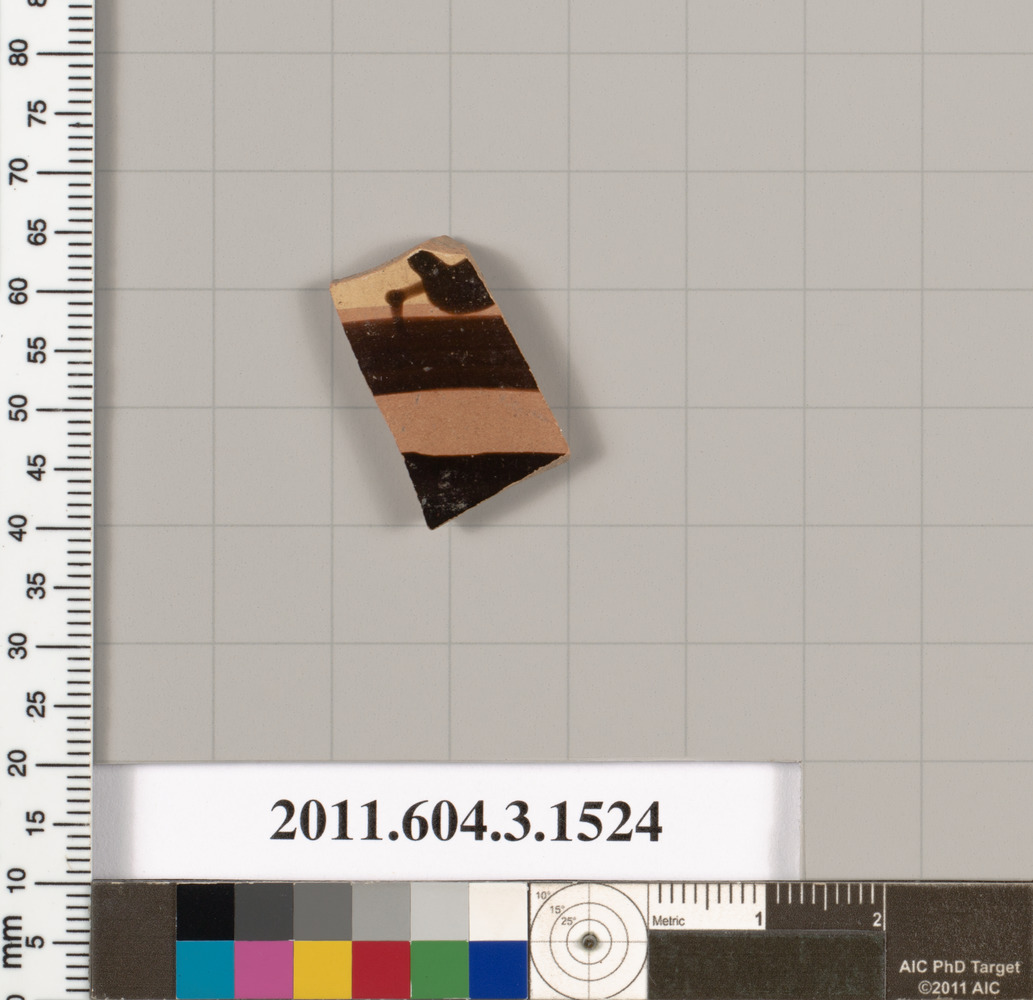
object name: skyphos fragment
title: Terracotta fragment of a skyphos (deep drinking cup)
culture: greek, attic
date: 534-468 BCE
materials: terracotta